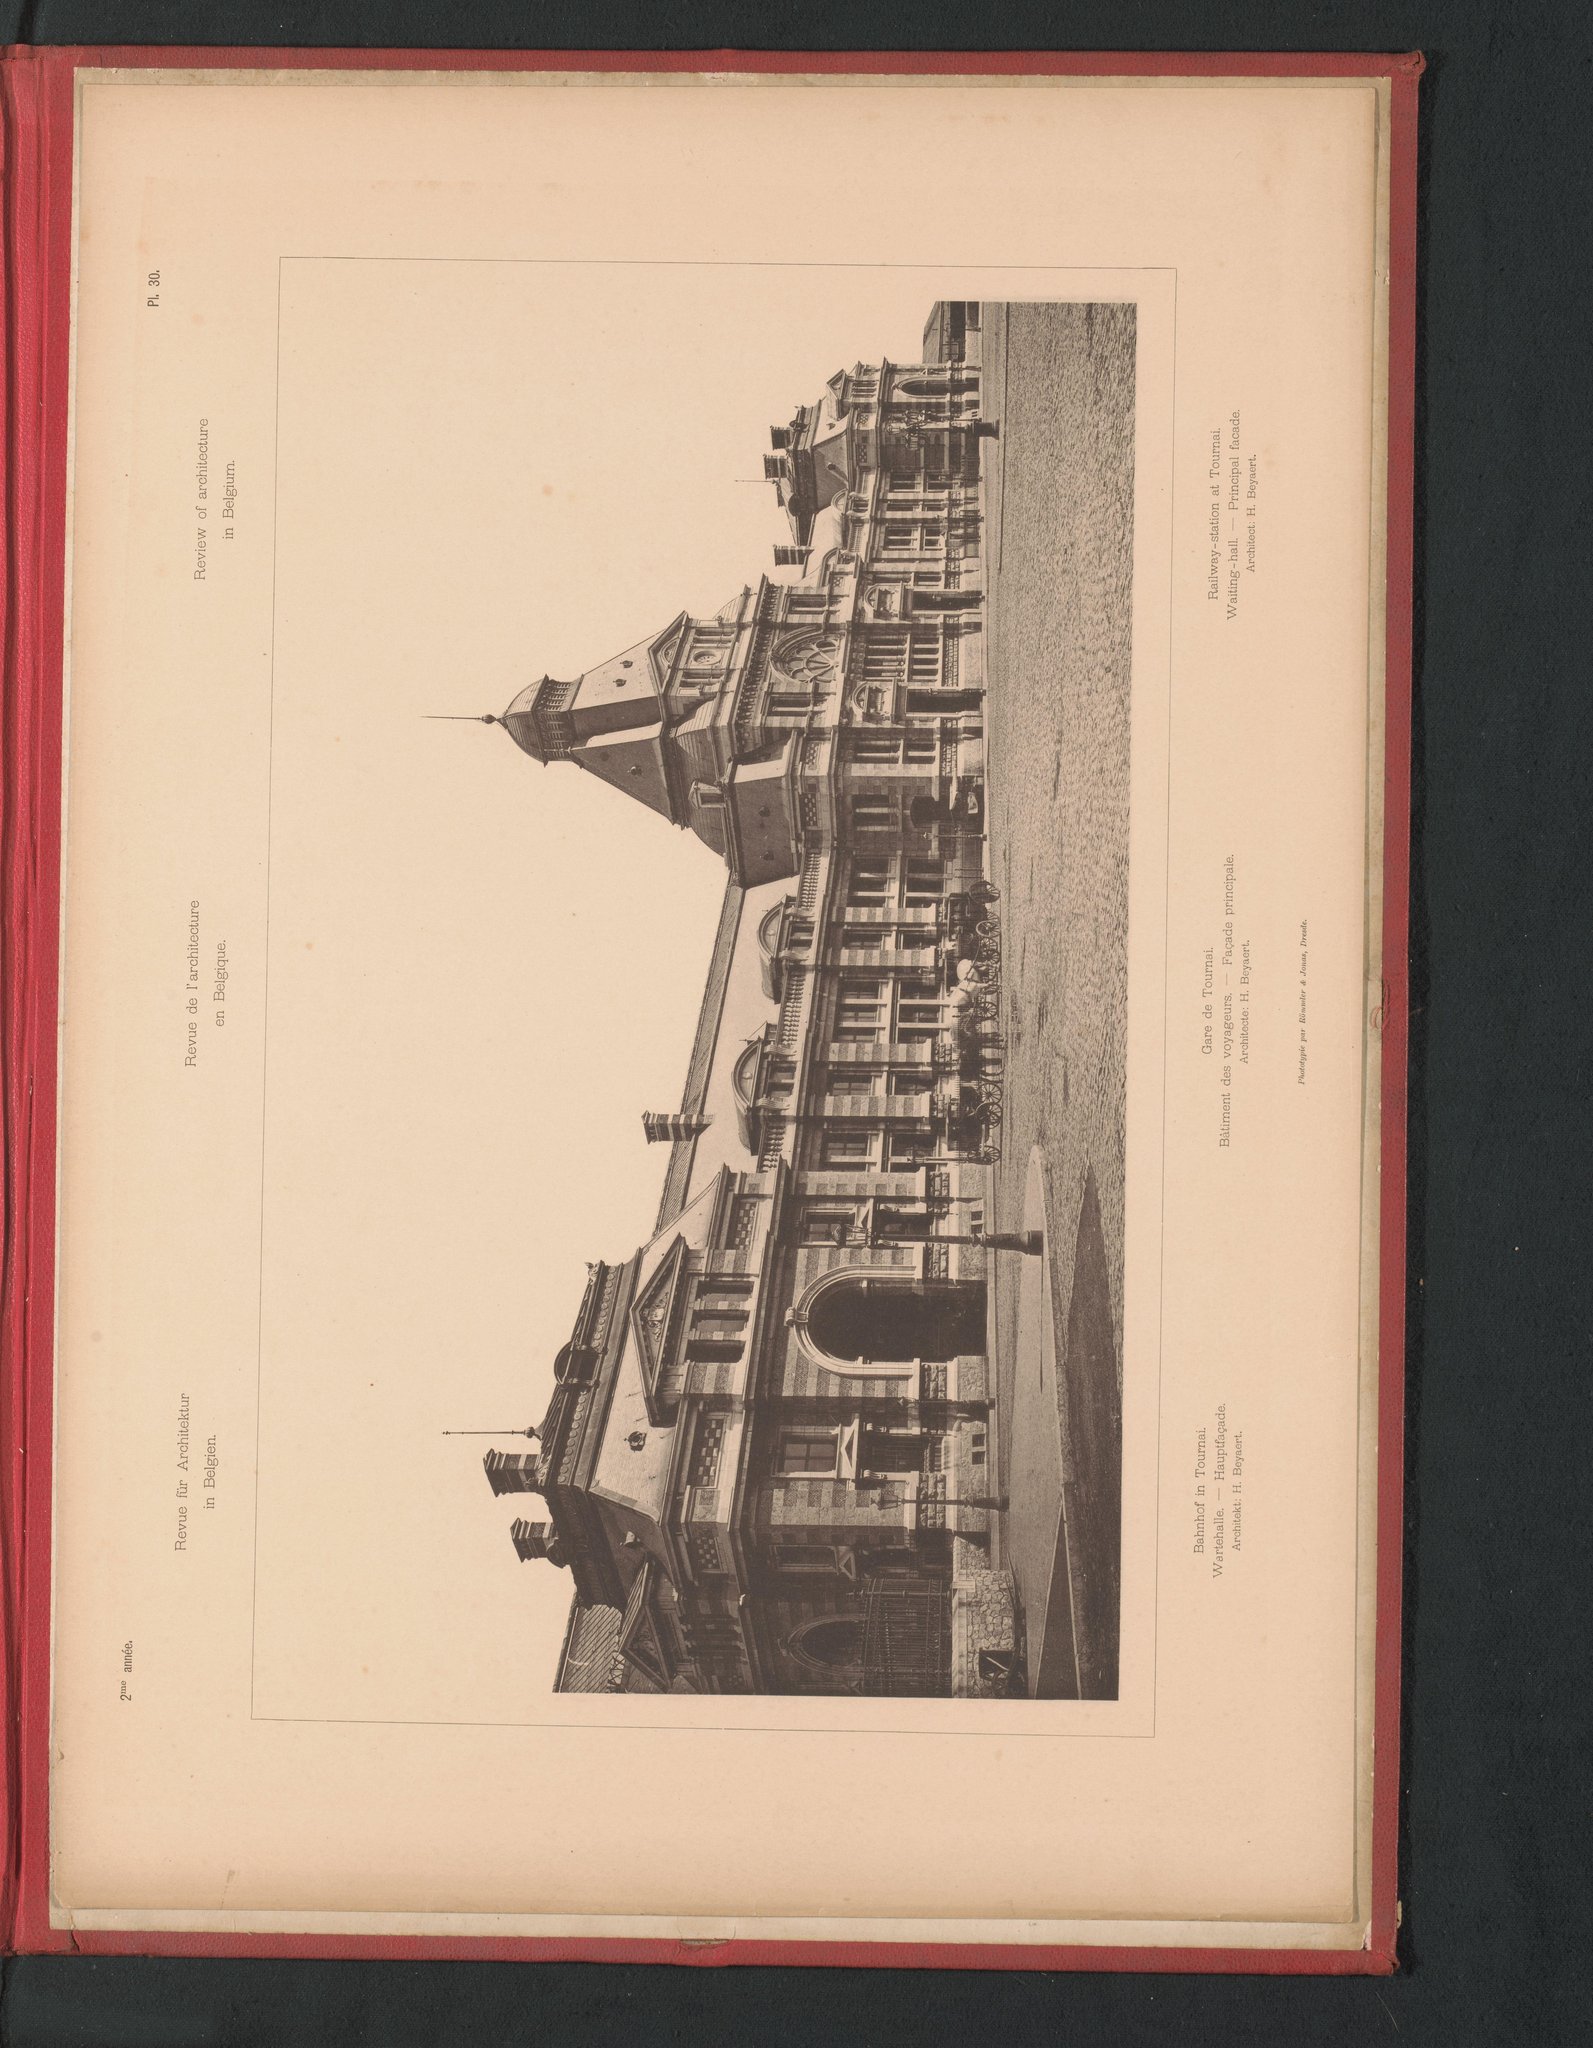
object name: photomechanical print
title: Revue de l'architecture en Belgique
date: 1888-1893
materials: paper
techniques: photograph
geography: dresden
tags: station; shelter (railway, tramway)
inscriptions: number: ‘Pl. 30.’, inscription: ‘2me année.’, inscription: ‘Architekt: H. Beyaert.’, inscription: ‘Architecte: H. Beyaert.’, inscription: ‘Architect: H. Beyaert.’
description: Deze prent maakt deel uit van een omslag met 110 prenten op 90 bladen en 18 tekstbladen.